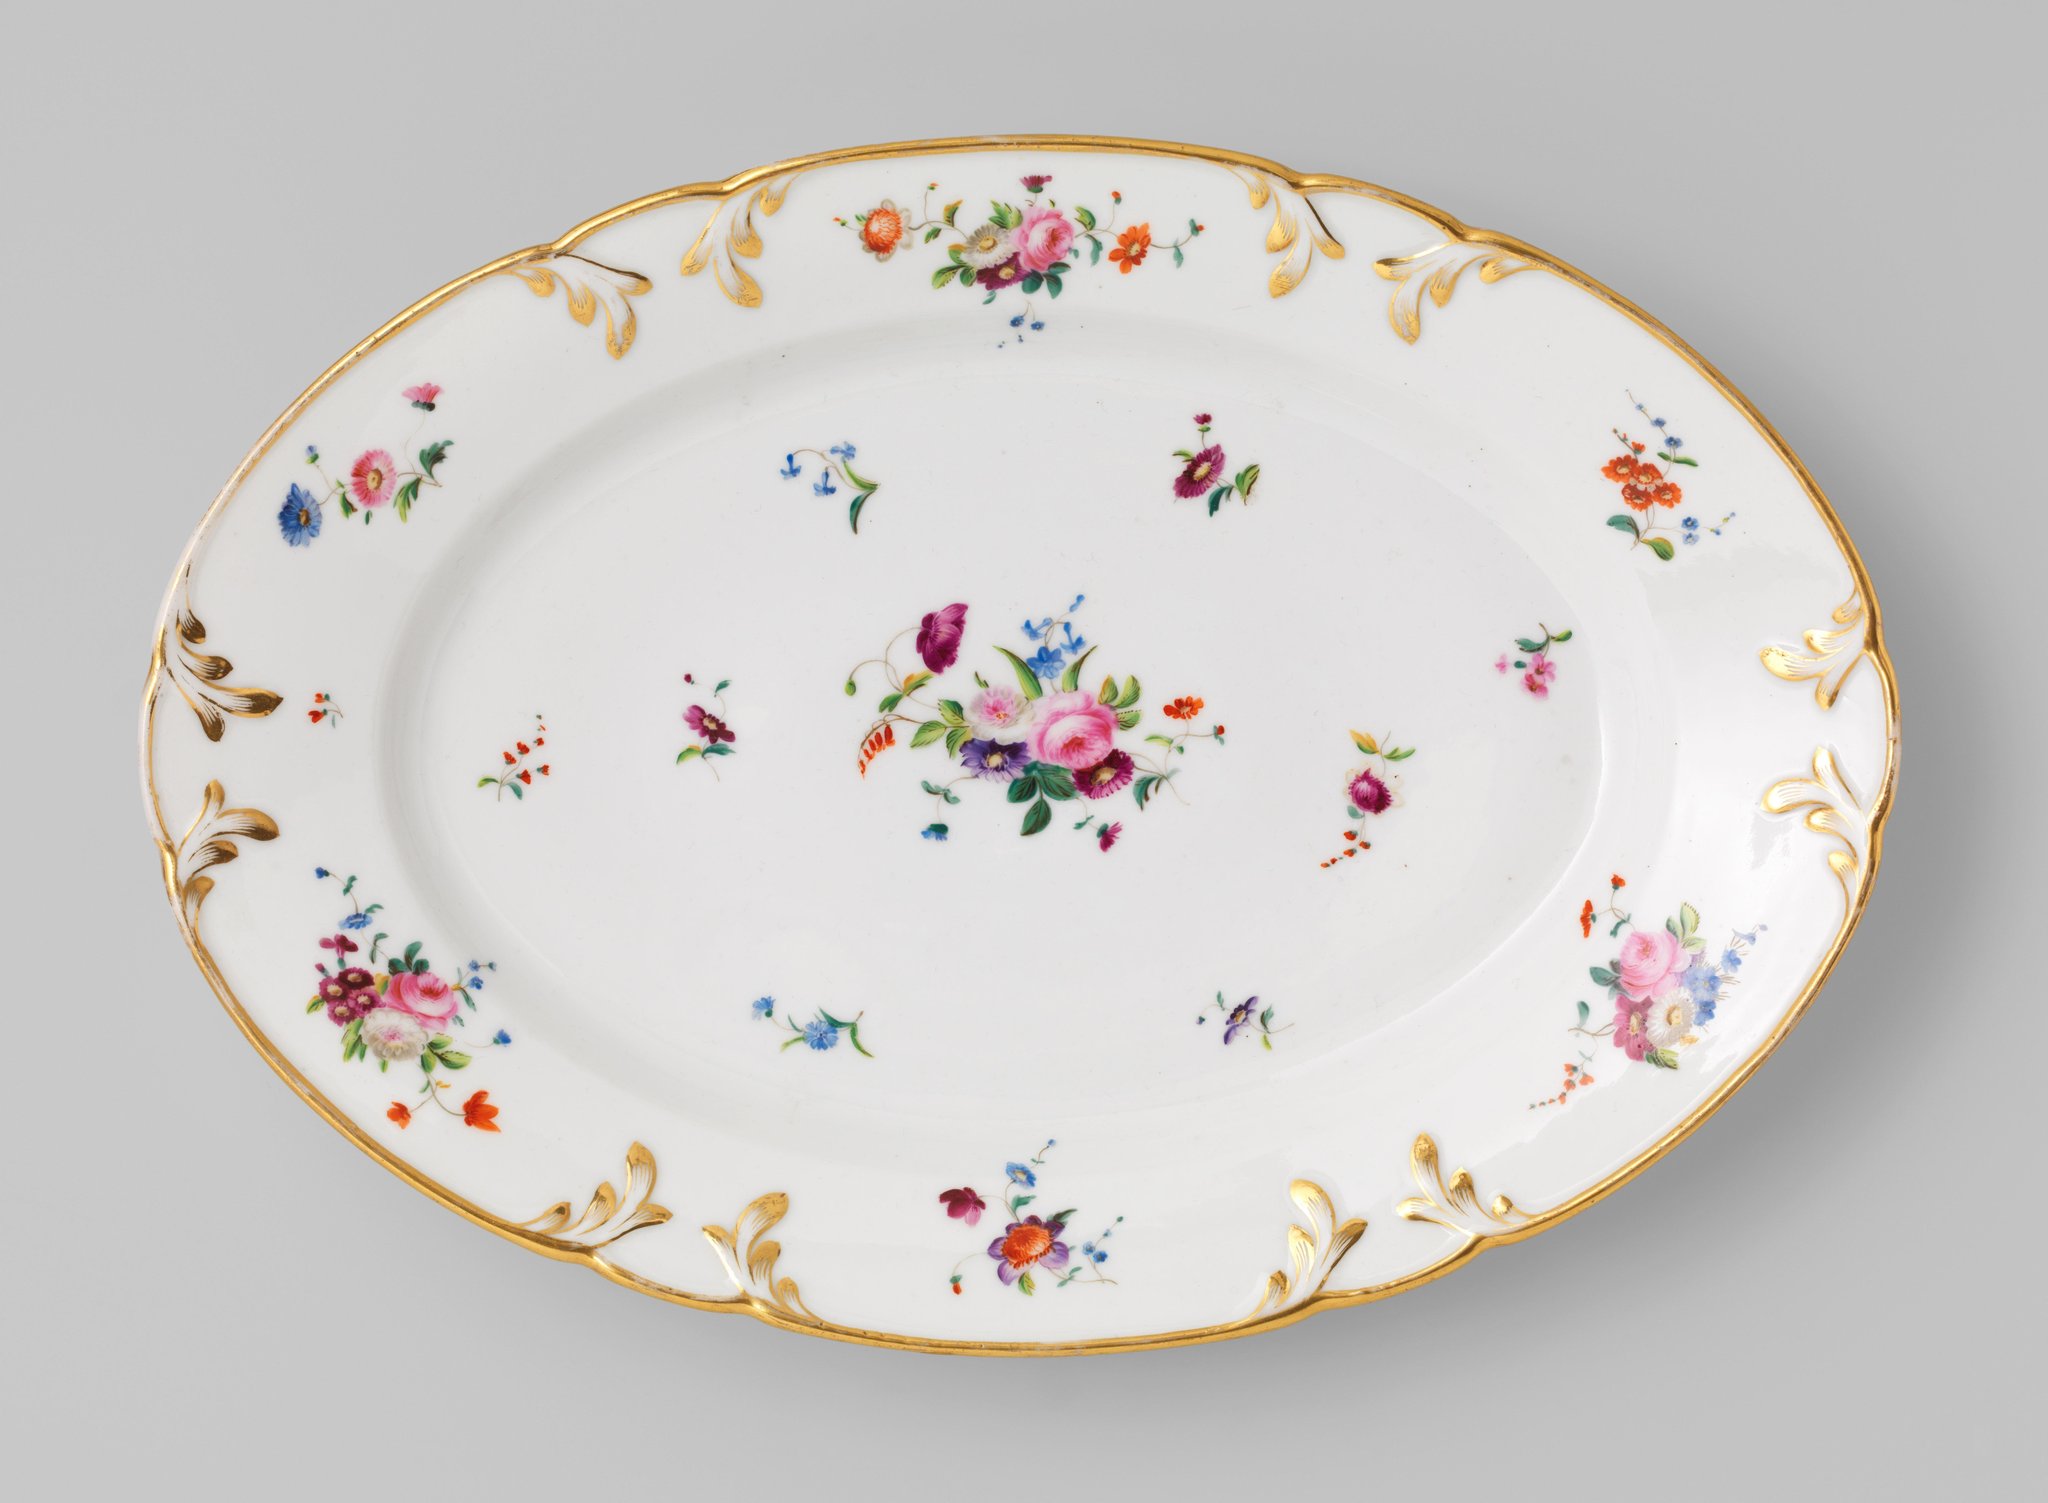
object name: platter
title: Dish with bouquets and flower sprays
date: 1839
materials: glaze, gold, paint, porcelain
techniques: firing, forming, gilding, turning, vitrification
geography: paris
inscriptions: mark: ‘DENUELLE/ Boulevard St. Denis 18/ à Paris’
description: Ovale schotel van porselein met een gelobde rand, beschilderd op het glazuur in blauw, rood, roze, groen, geel, paars, zwart en goud. Op het plat boeketten van verschillende bloemen en strooibloemen. Vanuit de gelobde, gouden rand, gemodelleerde bladranken in reliëf, aangezet met goud. Hiertussen boeketten. Dubbele voetring. Gemerkt op de onderzijde met 'DENUELLE/ Boulevard St. Denis 18/ à Paris'.